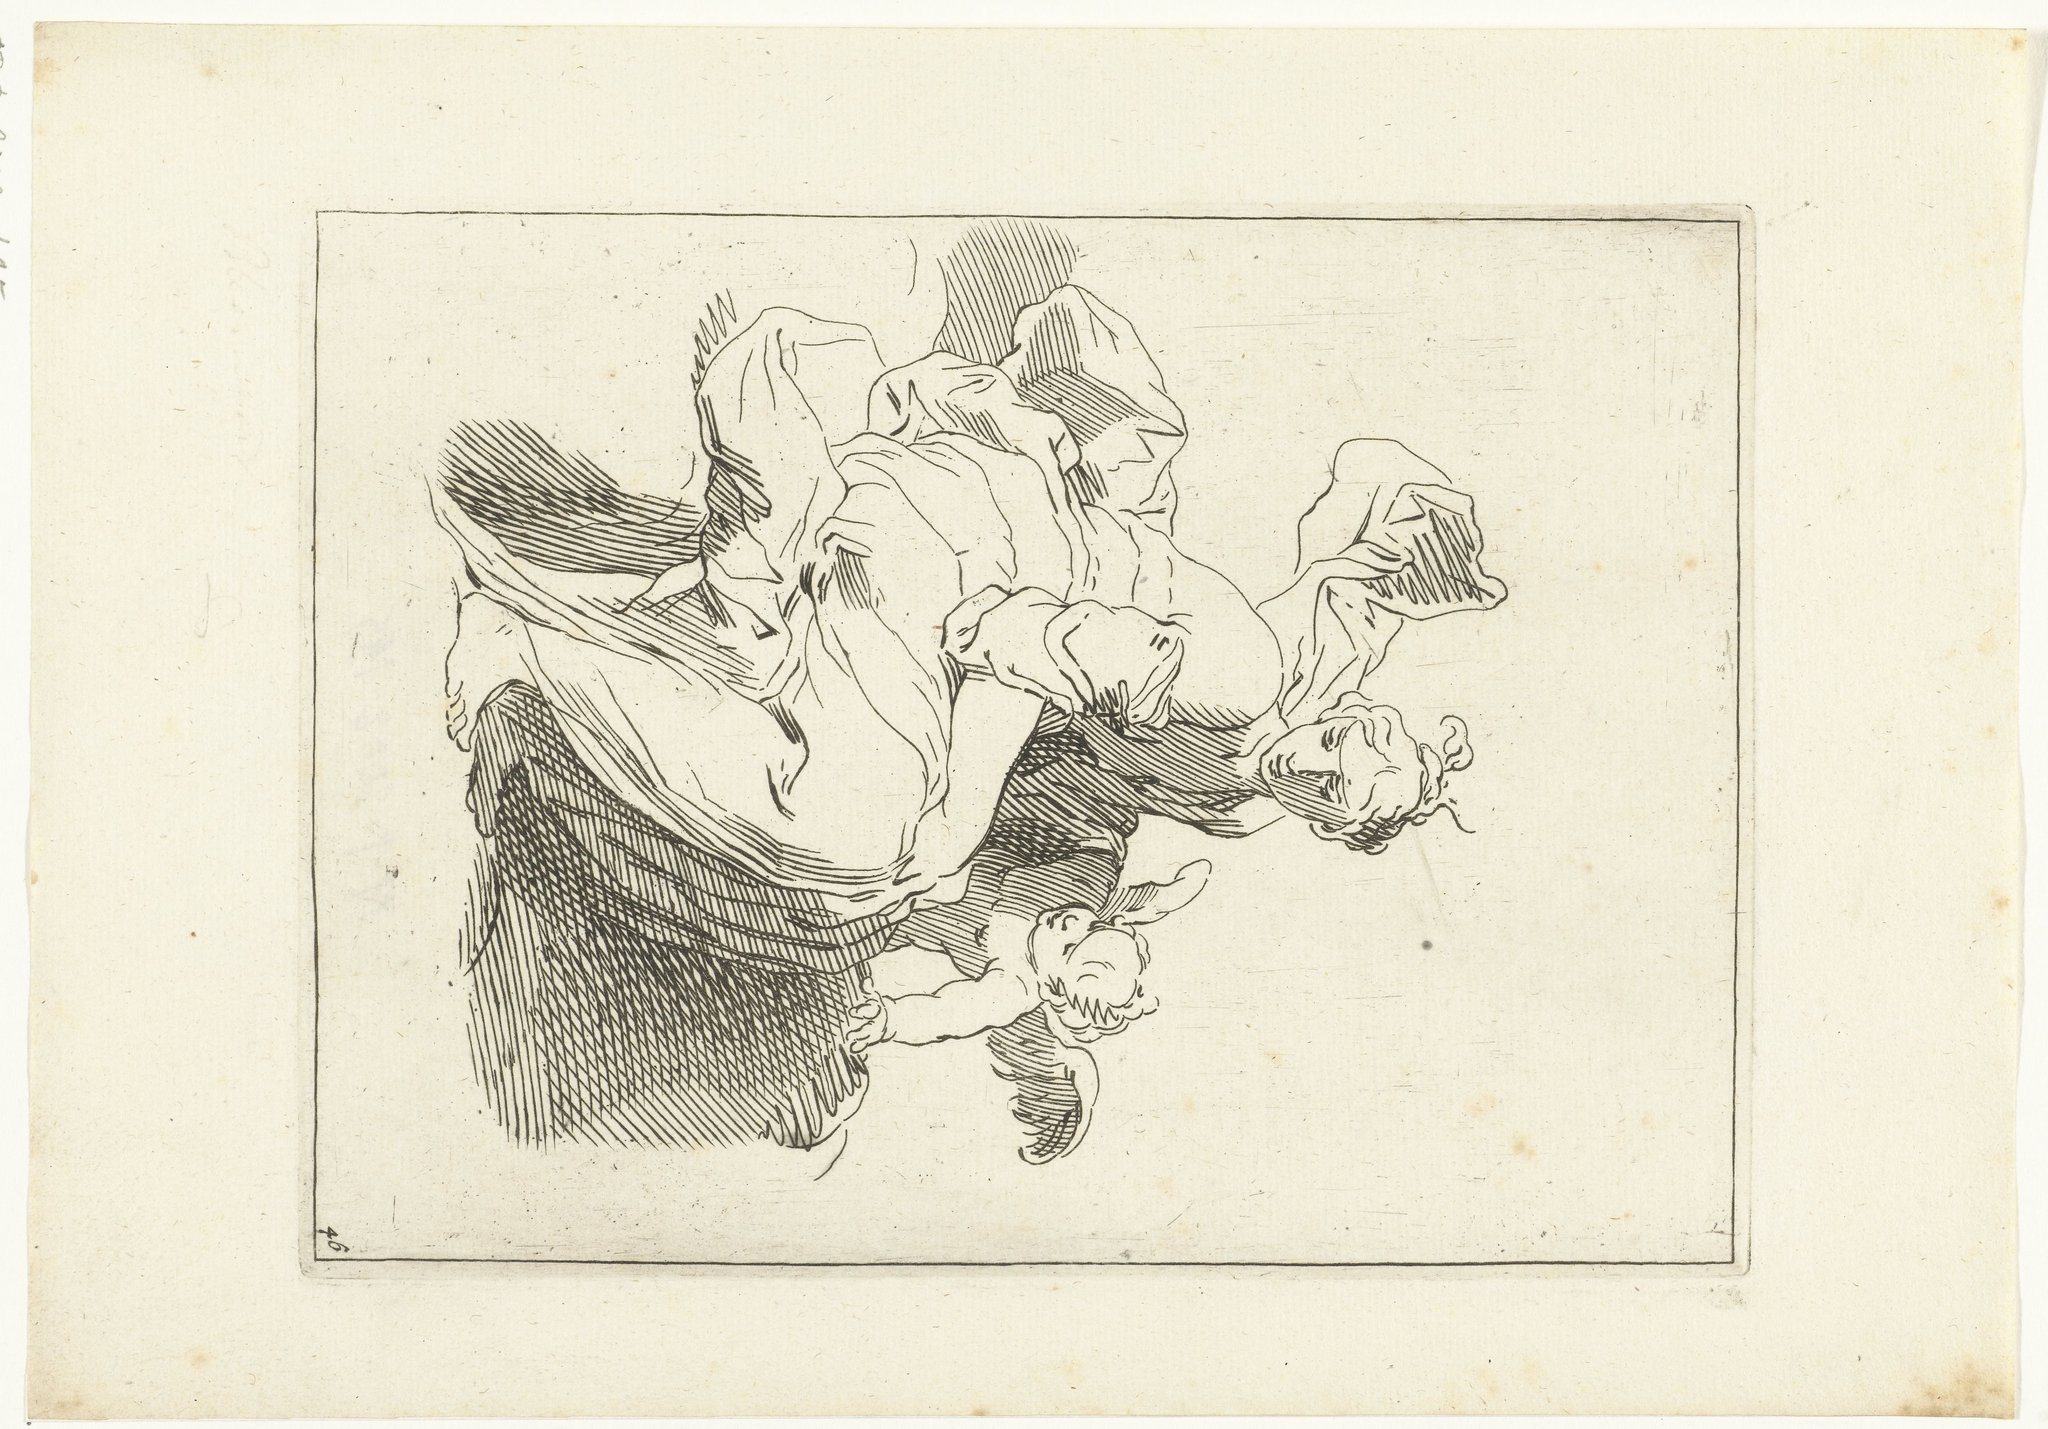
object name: print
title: Het tekenboek van Abraham Bloemaert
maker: Anonymous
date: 1679-1750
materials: paper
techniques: etching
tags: (story of) venus (aphrodite)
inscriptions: collector's mark: Lugt 2228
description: Venus in zittende houding. Cupido links van haar.